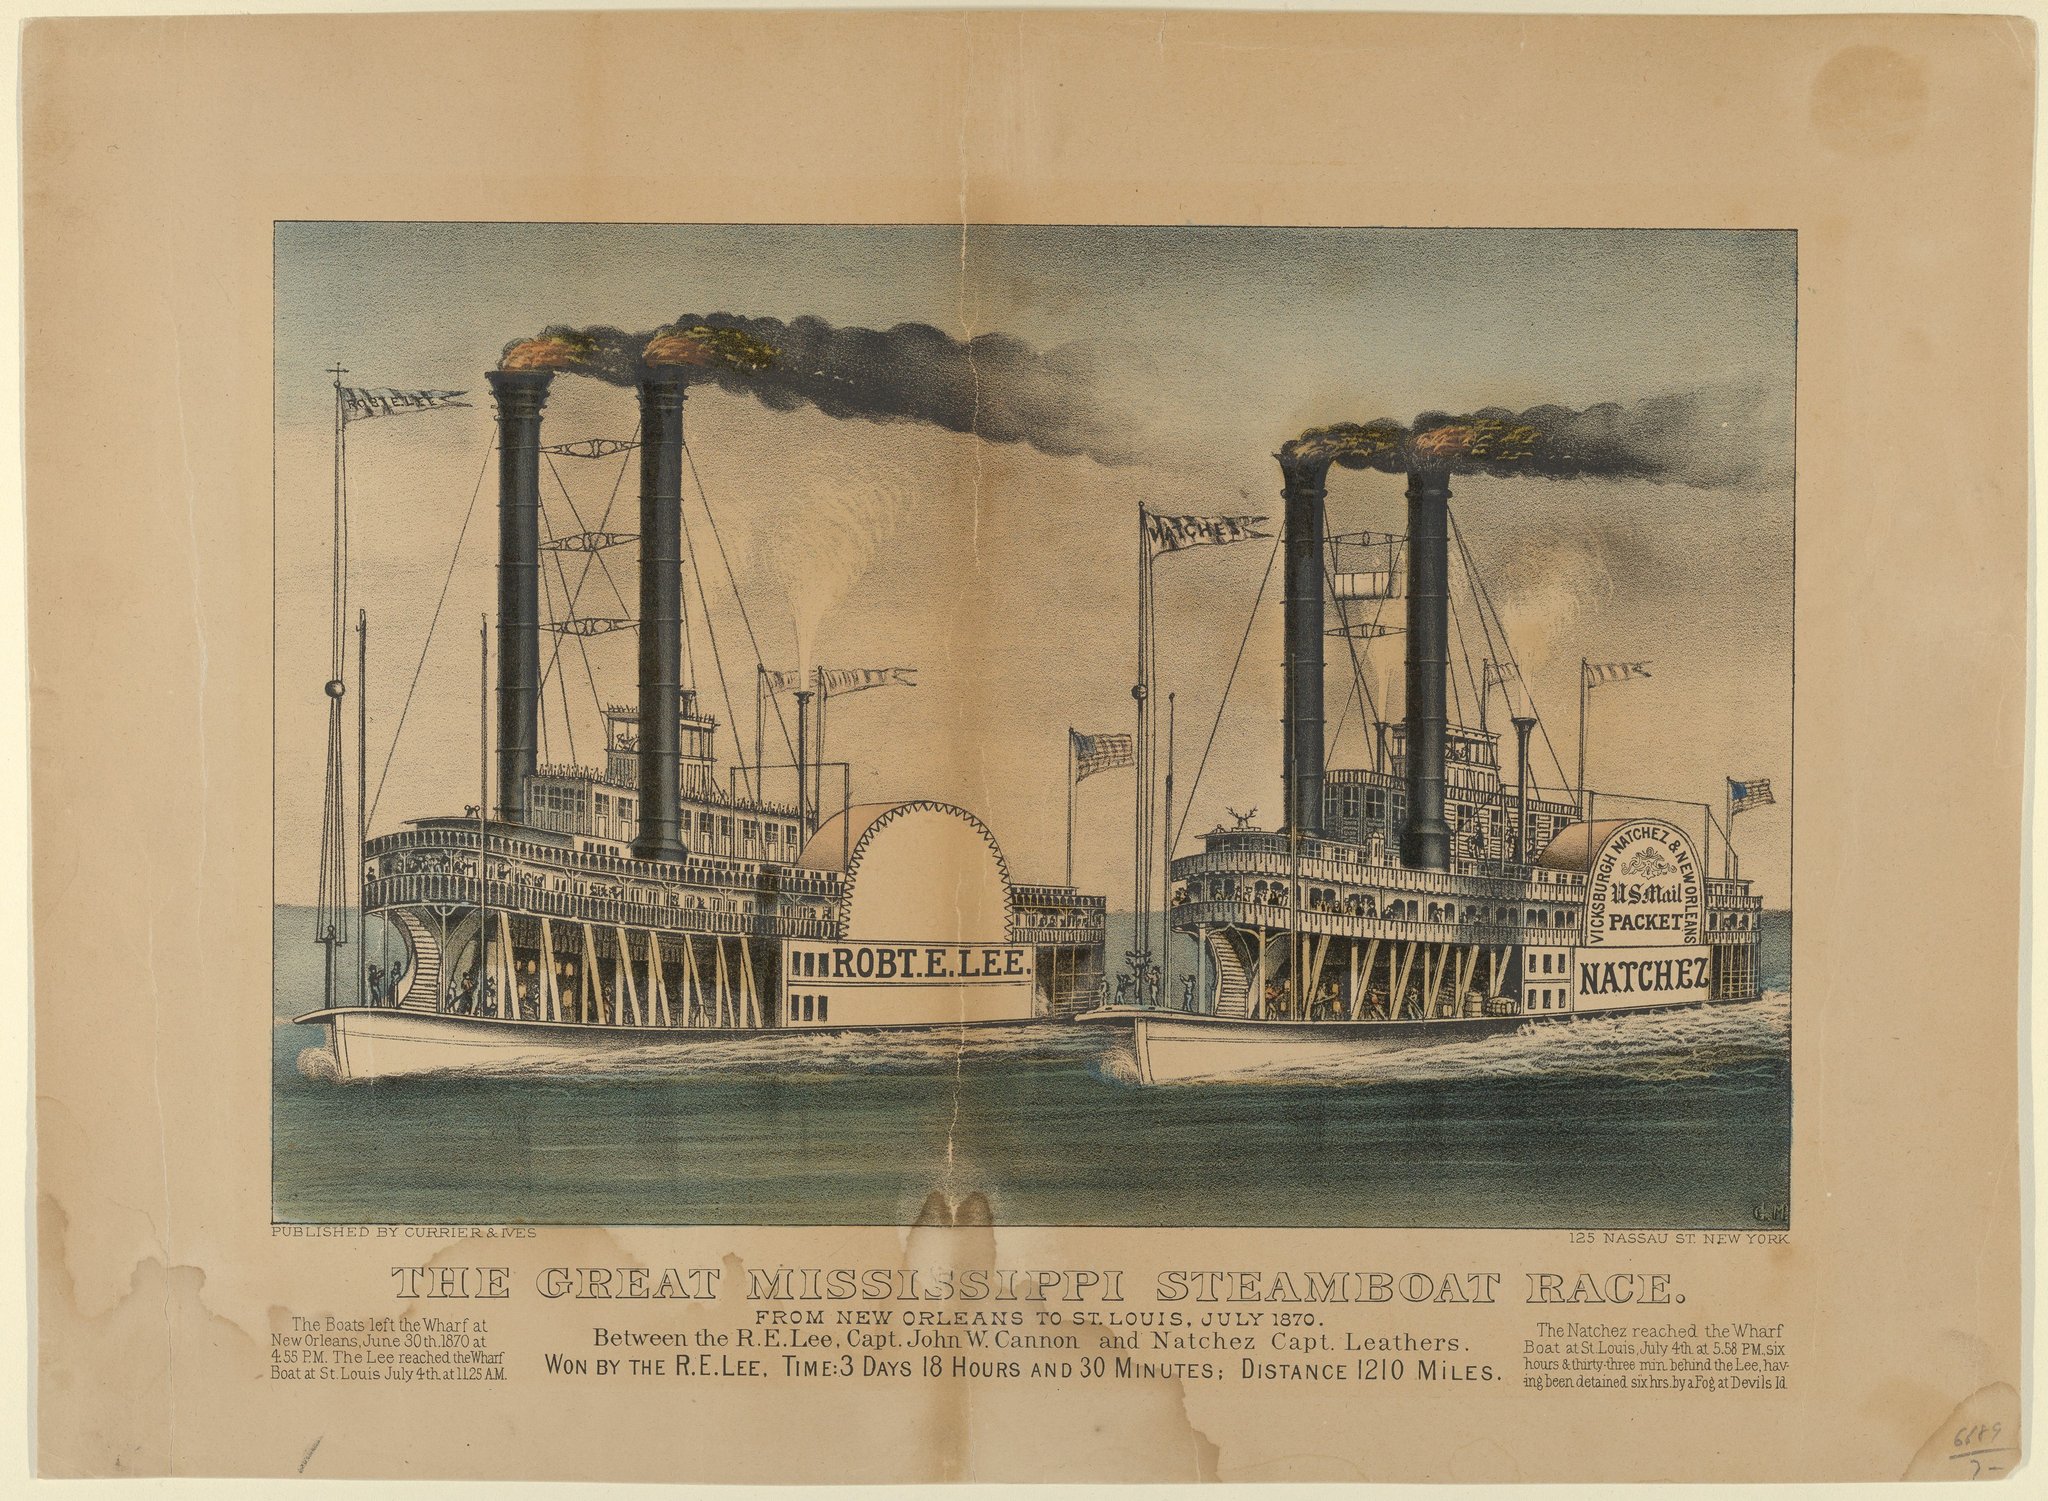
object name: print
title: The Great Mississippi Steamboat Race–From New Orleans to St. Louis, July 1870–Between the R.E. Lee, Captain John W. Cannon and Natchez Captain Leathers–Won by the R.E. Lee, Time: 3 Days 18 Hours and 30 Minutes; Distance 1210 Miles.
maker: currier & ives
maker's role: lithographer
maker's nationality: american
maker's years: 1857-1907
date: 1868-1878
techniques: hand coloring, lithograph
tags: rivers,boats